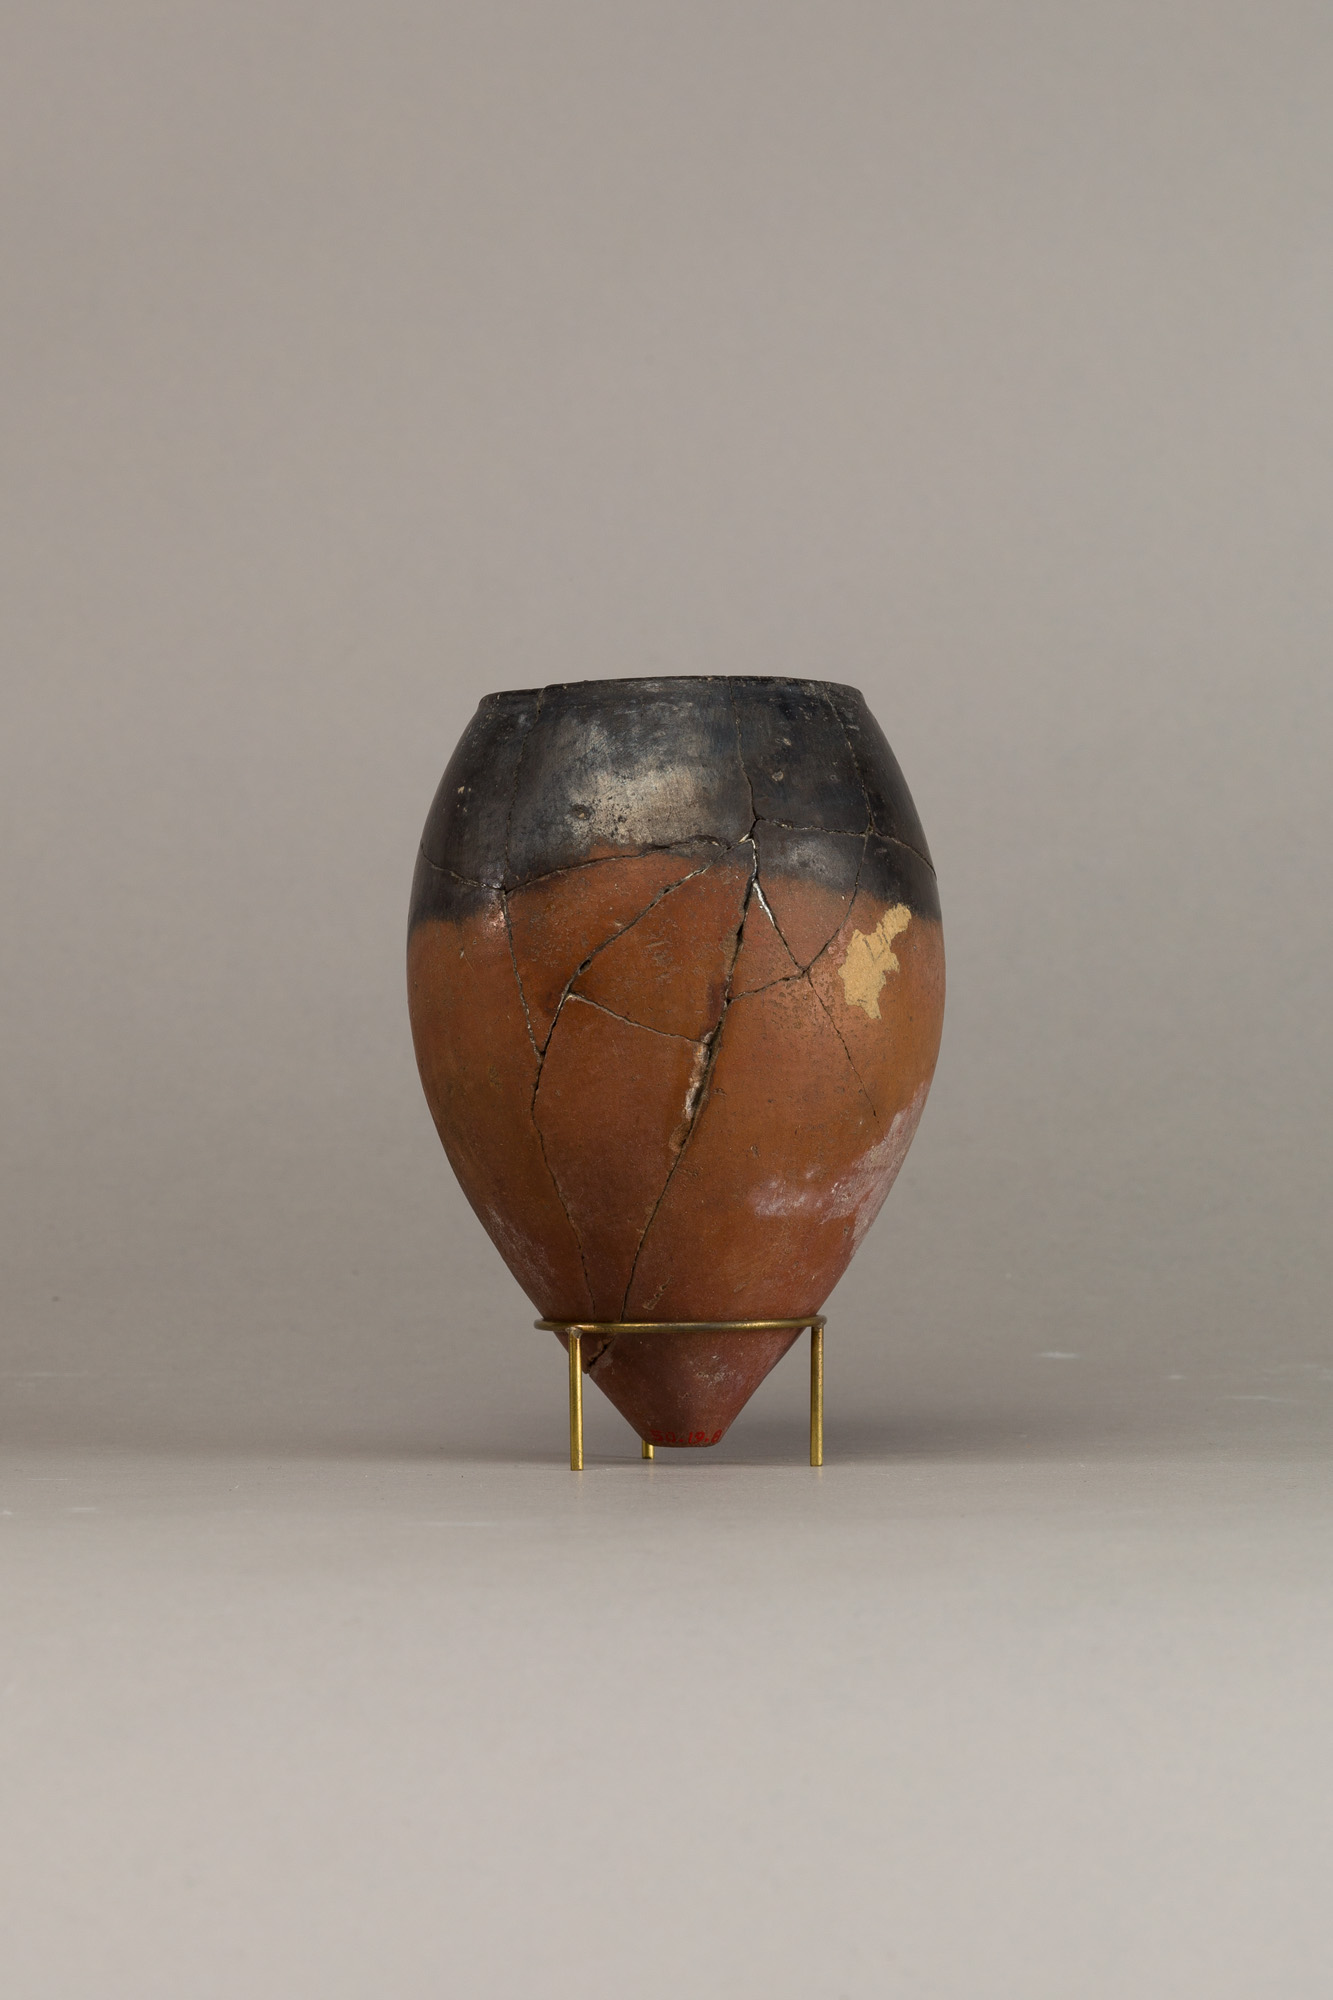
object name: jar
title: Black-topped red ware jar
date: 3850-2960 BCE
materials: pottery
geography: egypt